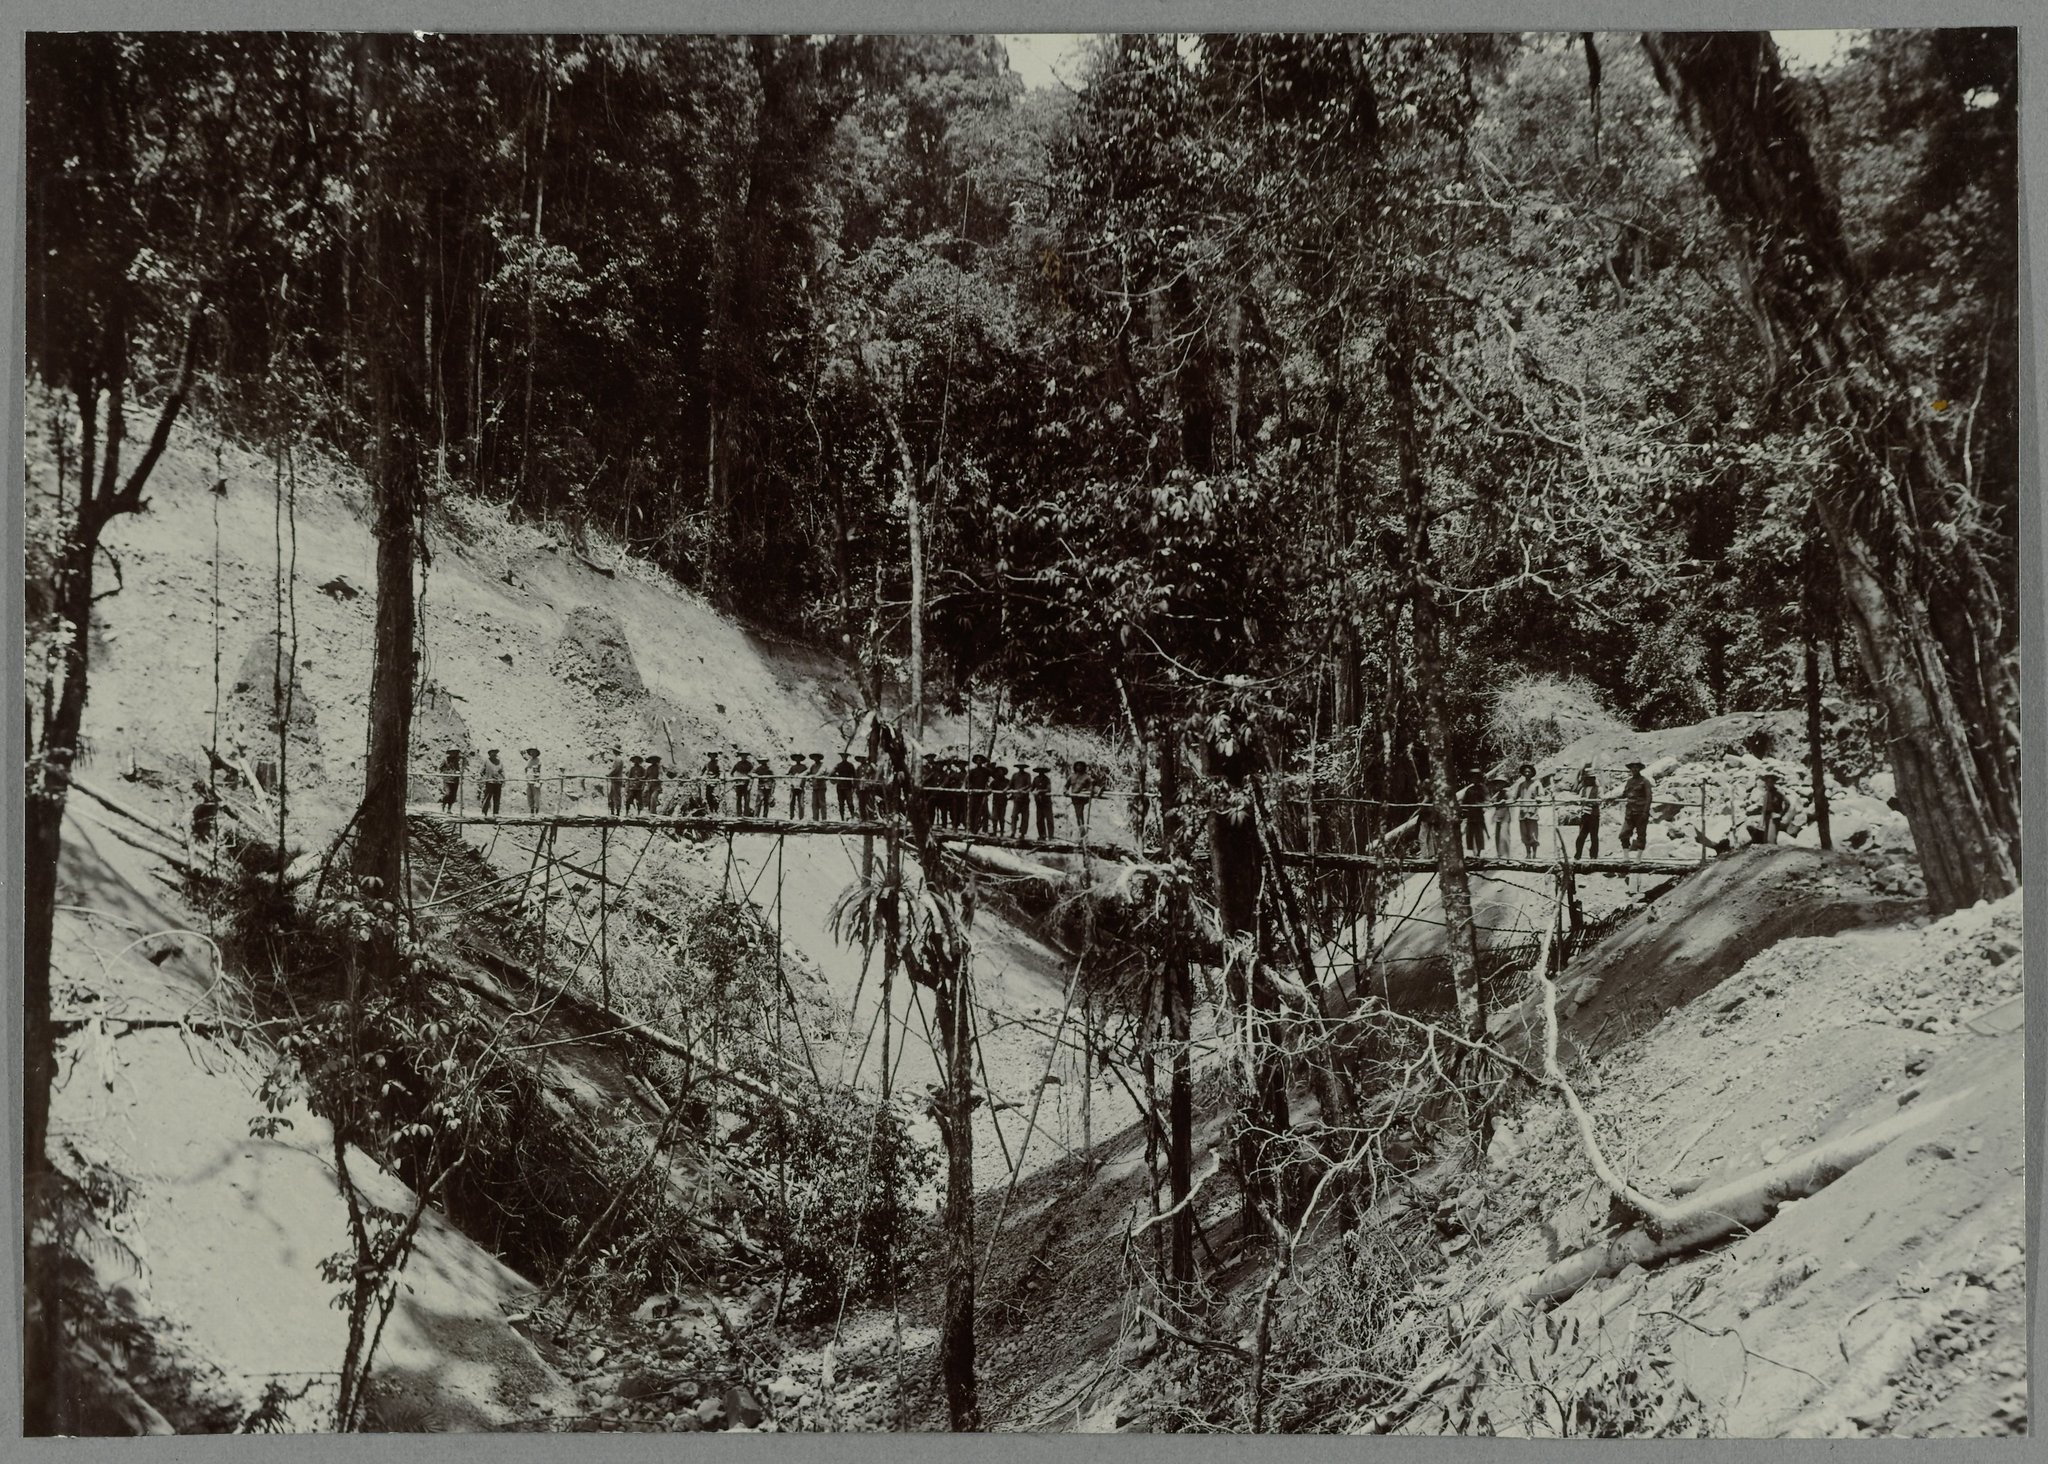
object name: photograph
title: Noodbrug over een ravijn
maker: Anonymous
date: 1903-1913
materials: photographic support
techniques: photography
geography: north sumatra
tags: arnhem, the hague, albertus dominicus laman trip, landscapes in tropical and sub-tropical regions, bridge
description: Na de expedities naar de Gajo- en Alaslanden o.l.v. Van Daalen (eerste tocht in 1901), werd hij in 1903 belast met voorbereiding van permanente vestiging van Nederlands gezag. Aanleg van een weg van de Noordkust naar het binnenland was hierbij van groot belang. Deze zgn. Gajoweg werd aangelegd tussen 1903 en 1914, van Bireuen aan de kust naar Takinguen aan het bergmeer Danau Lauttawar, totale lente 104 km.